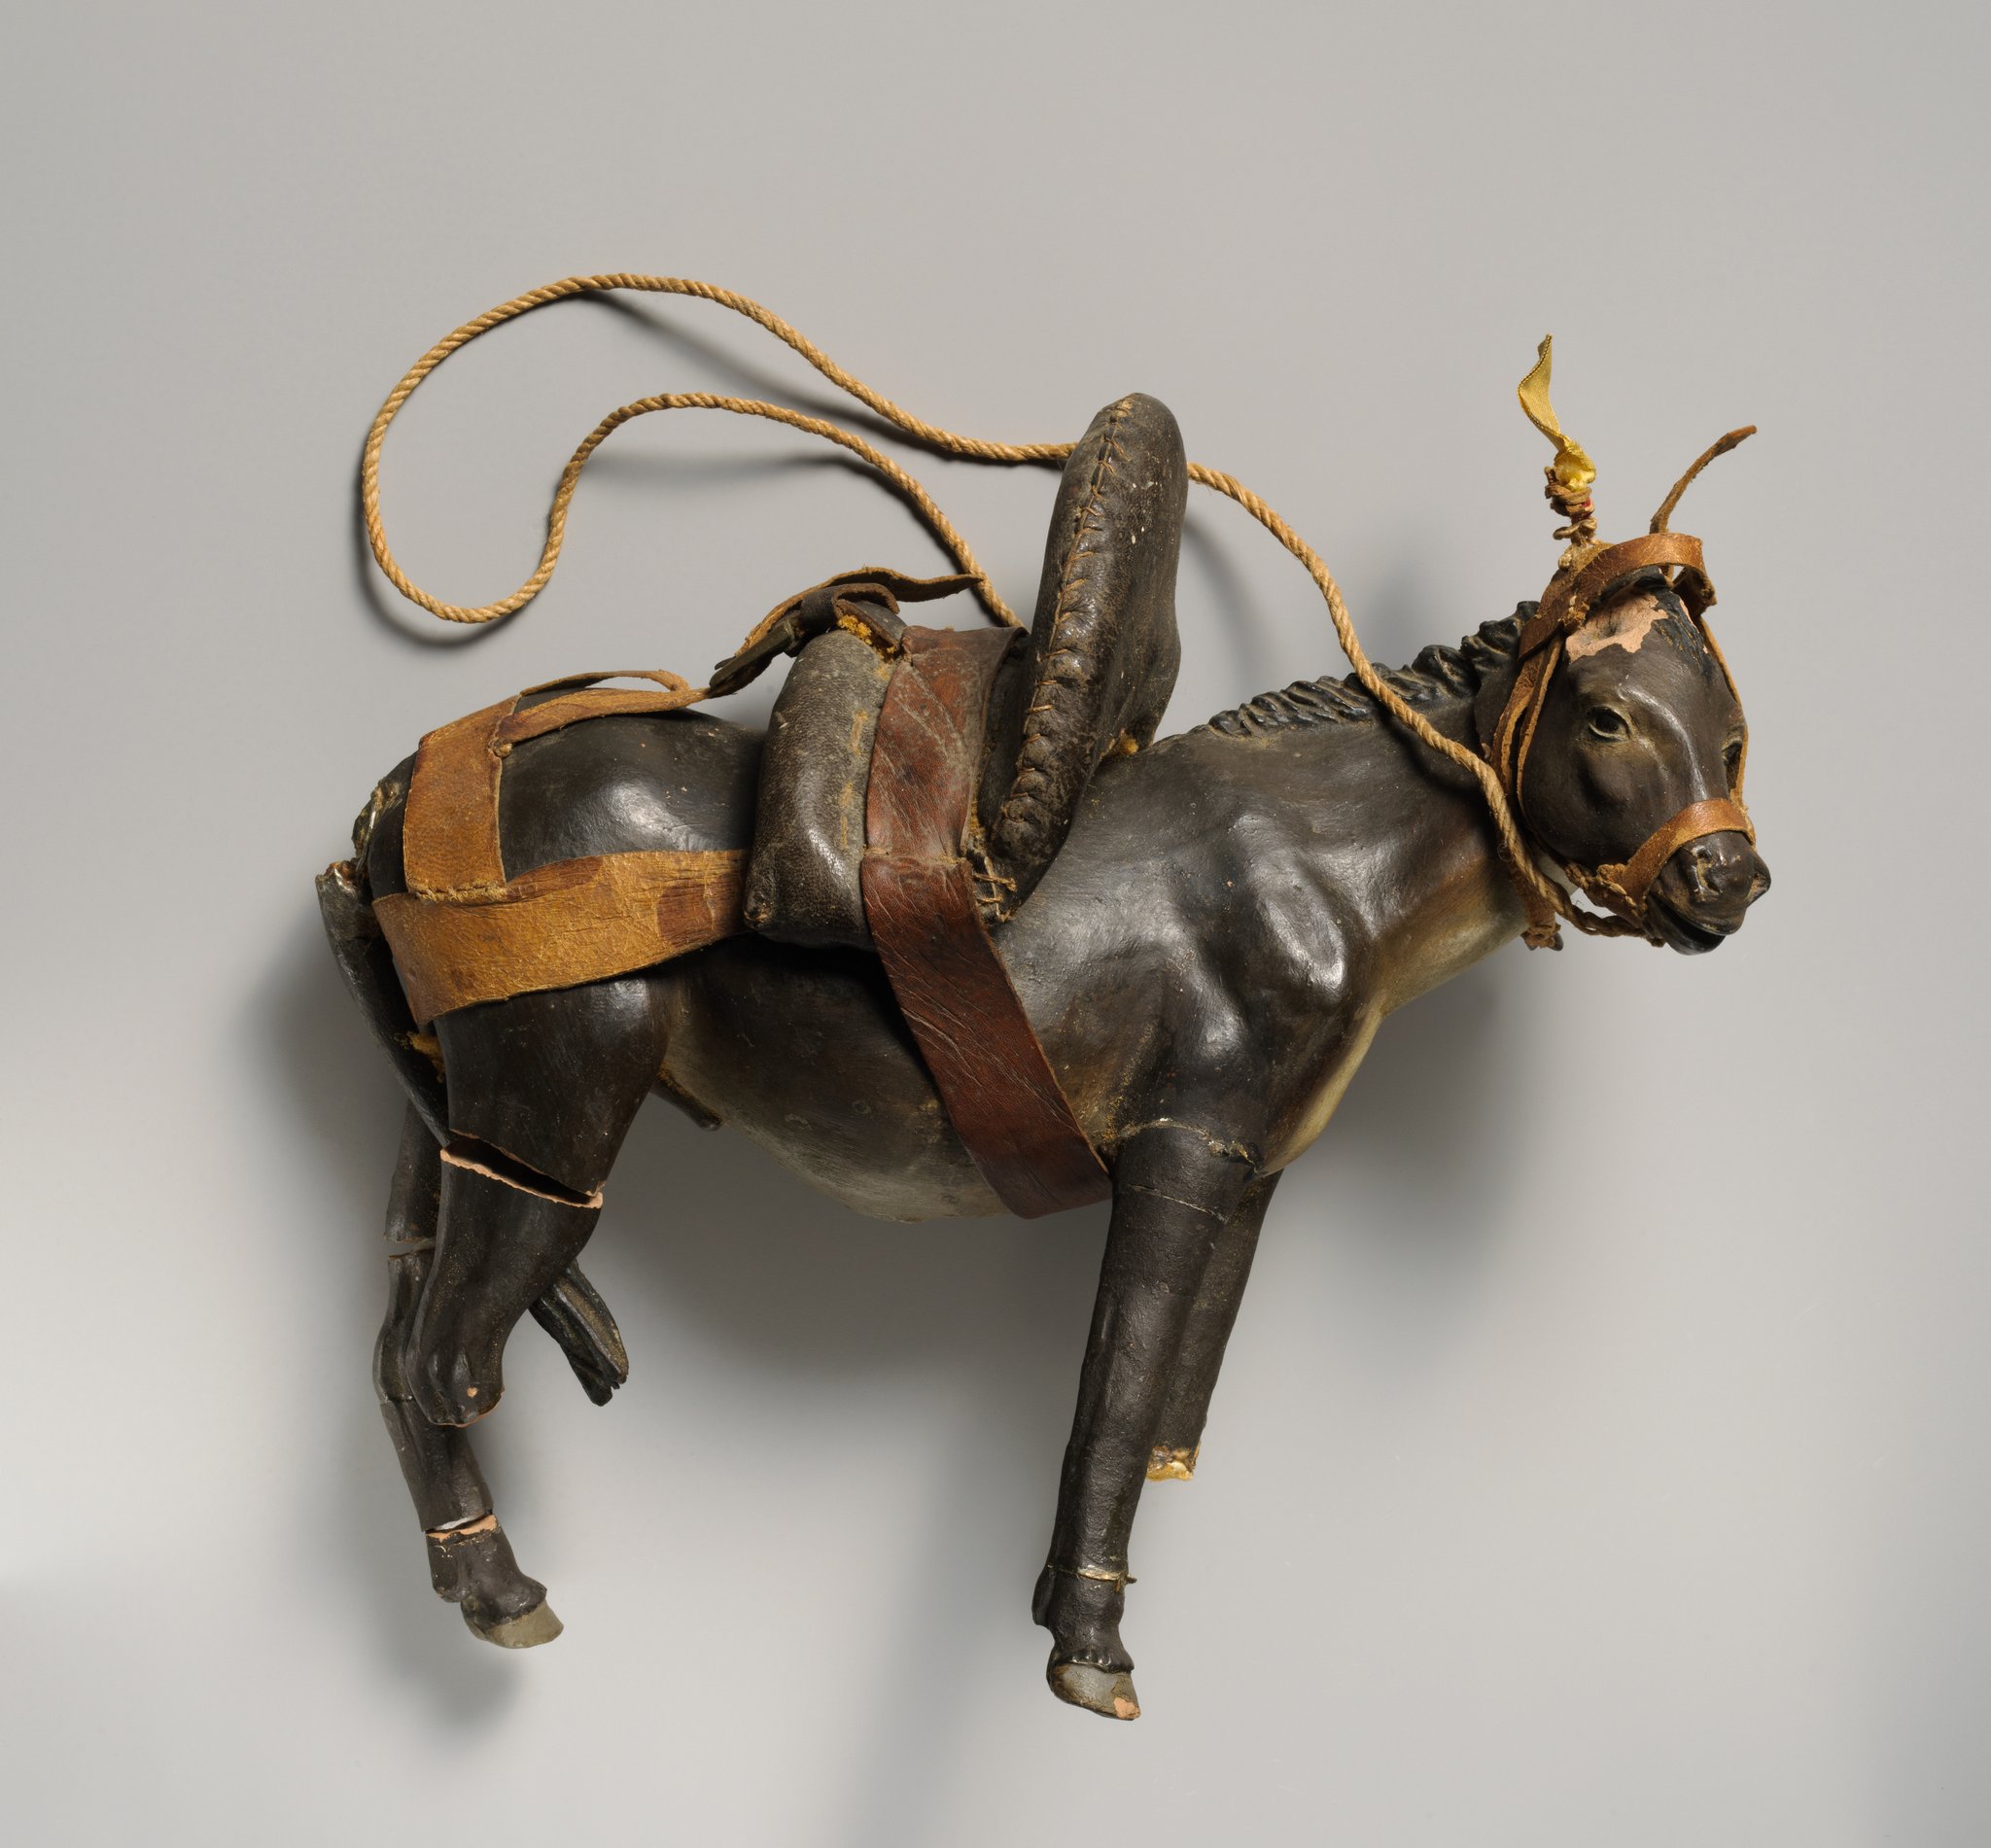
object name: crèche figure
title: Donkey with saddle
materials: leather, terracotta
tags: donkeys